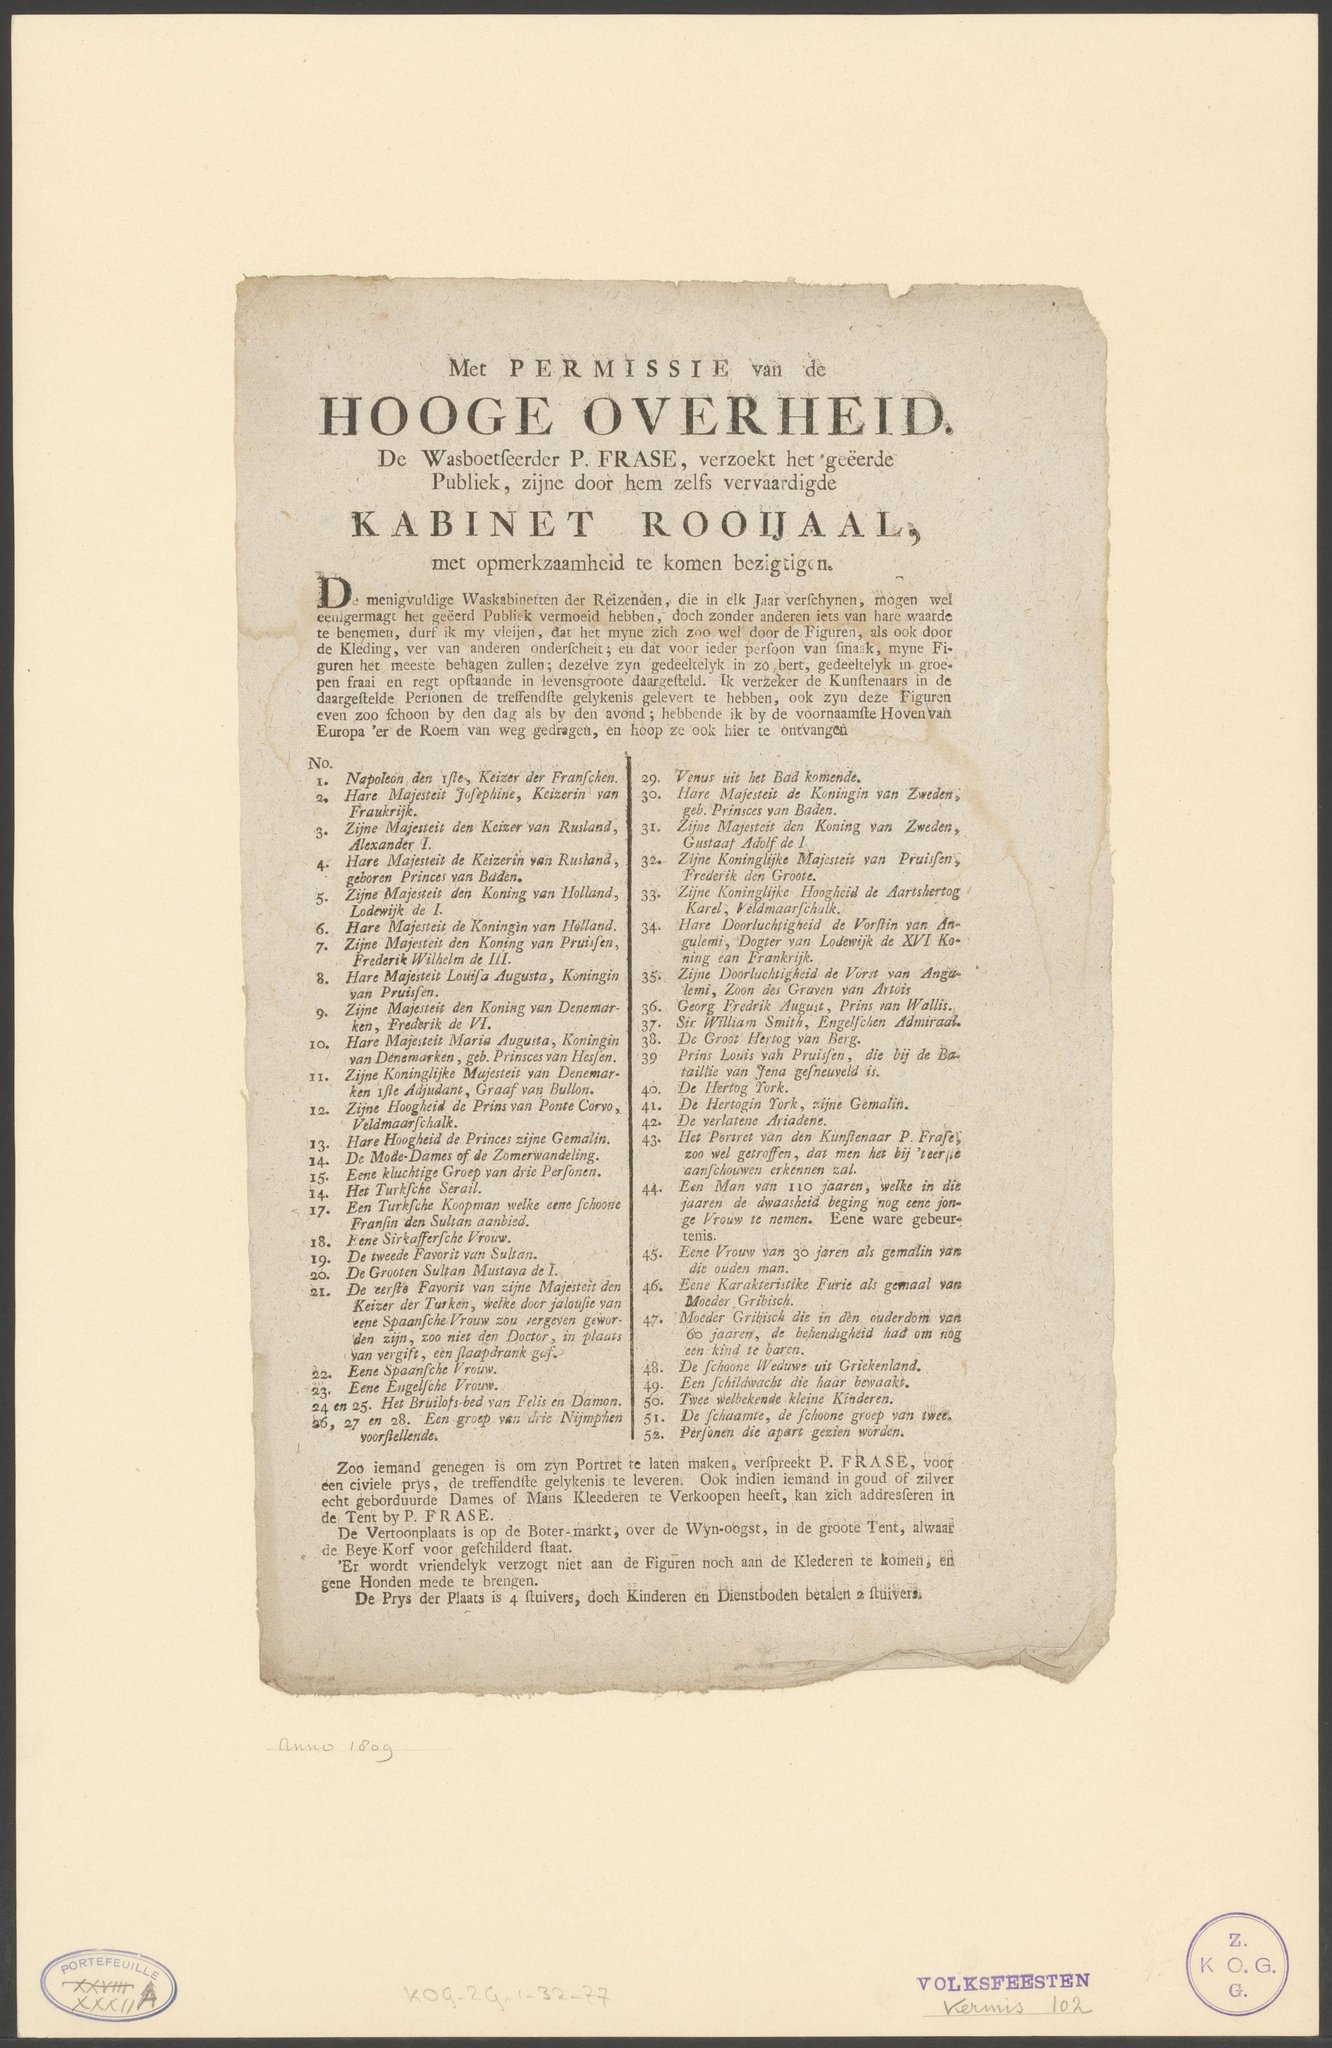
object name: reclamebiljet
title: De Wasboetseerder P. Frase, verzoekt het geëerde Publiek, zijne door hem zelfs vervaardigde Kabinet Rooijaal, met opmerkzaamheid te komen bezigtigen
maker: Anonymous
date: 1809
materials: paper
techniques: letterpress printing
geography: netherlands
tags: wax-figure cabinet, pleasure fair and circus, amsterdam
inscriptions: collector's mark, collector's mark: Lugt 1641